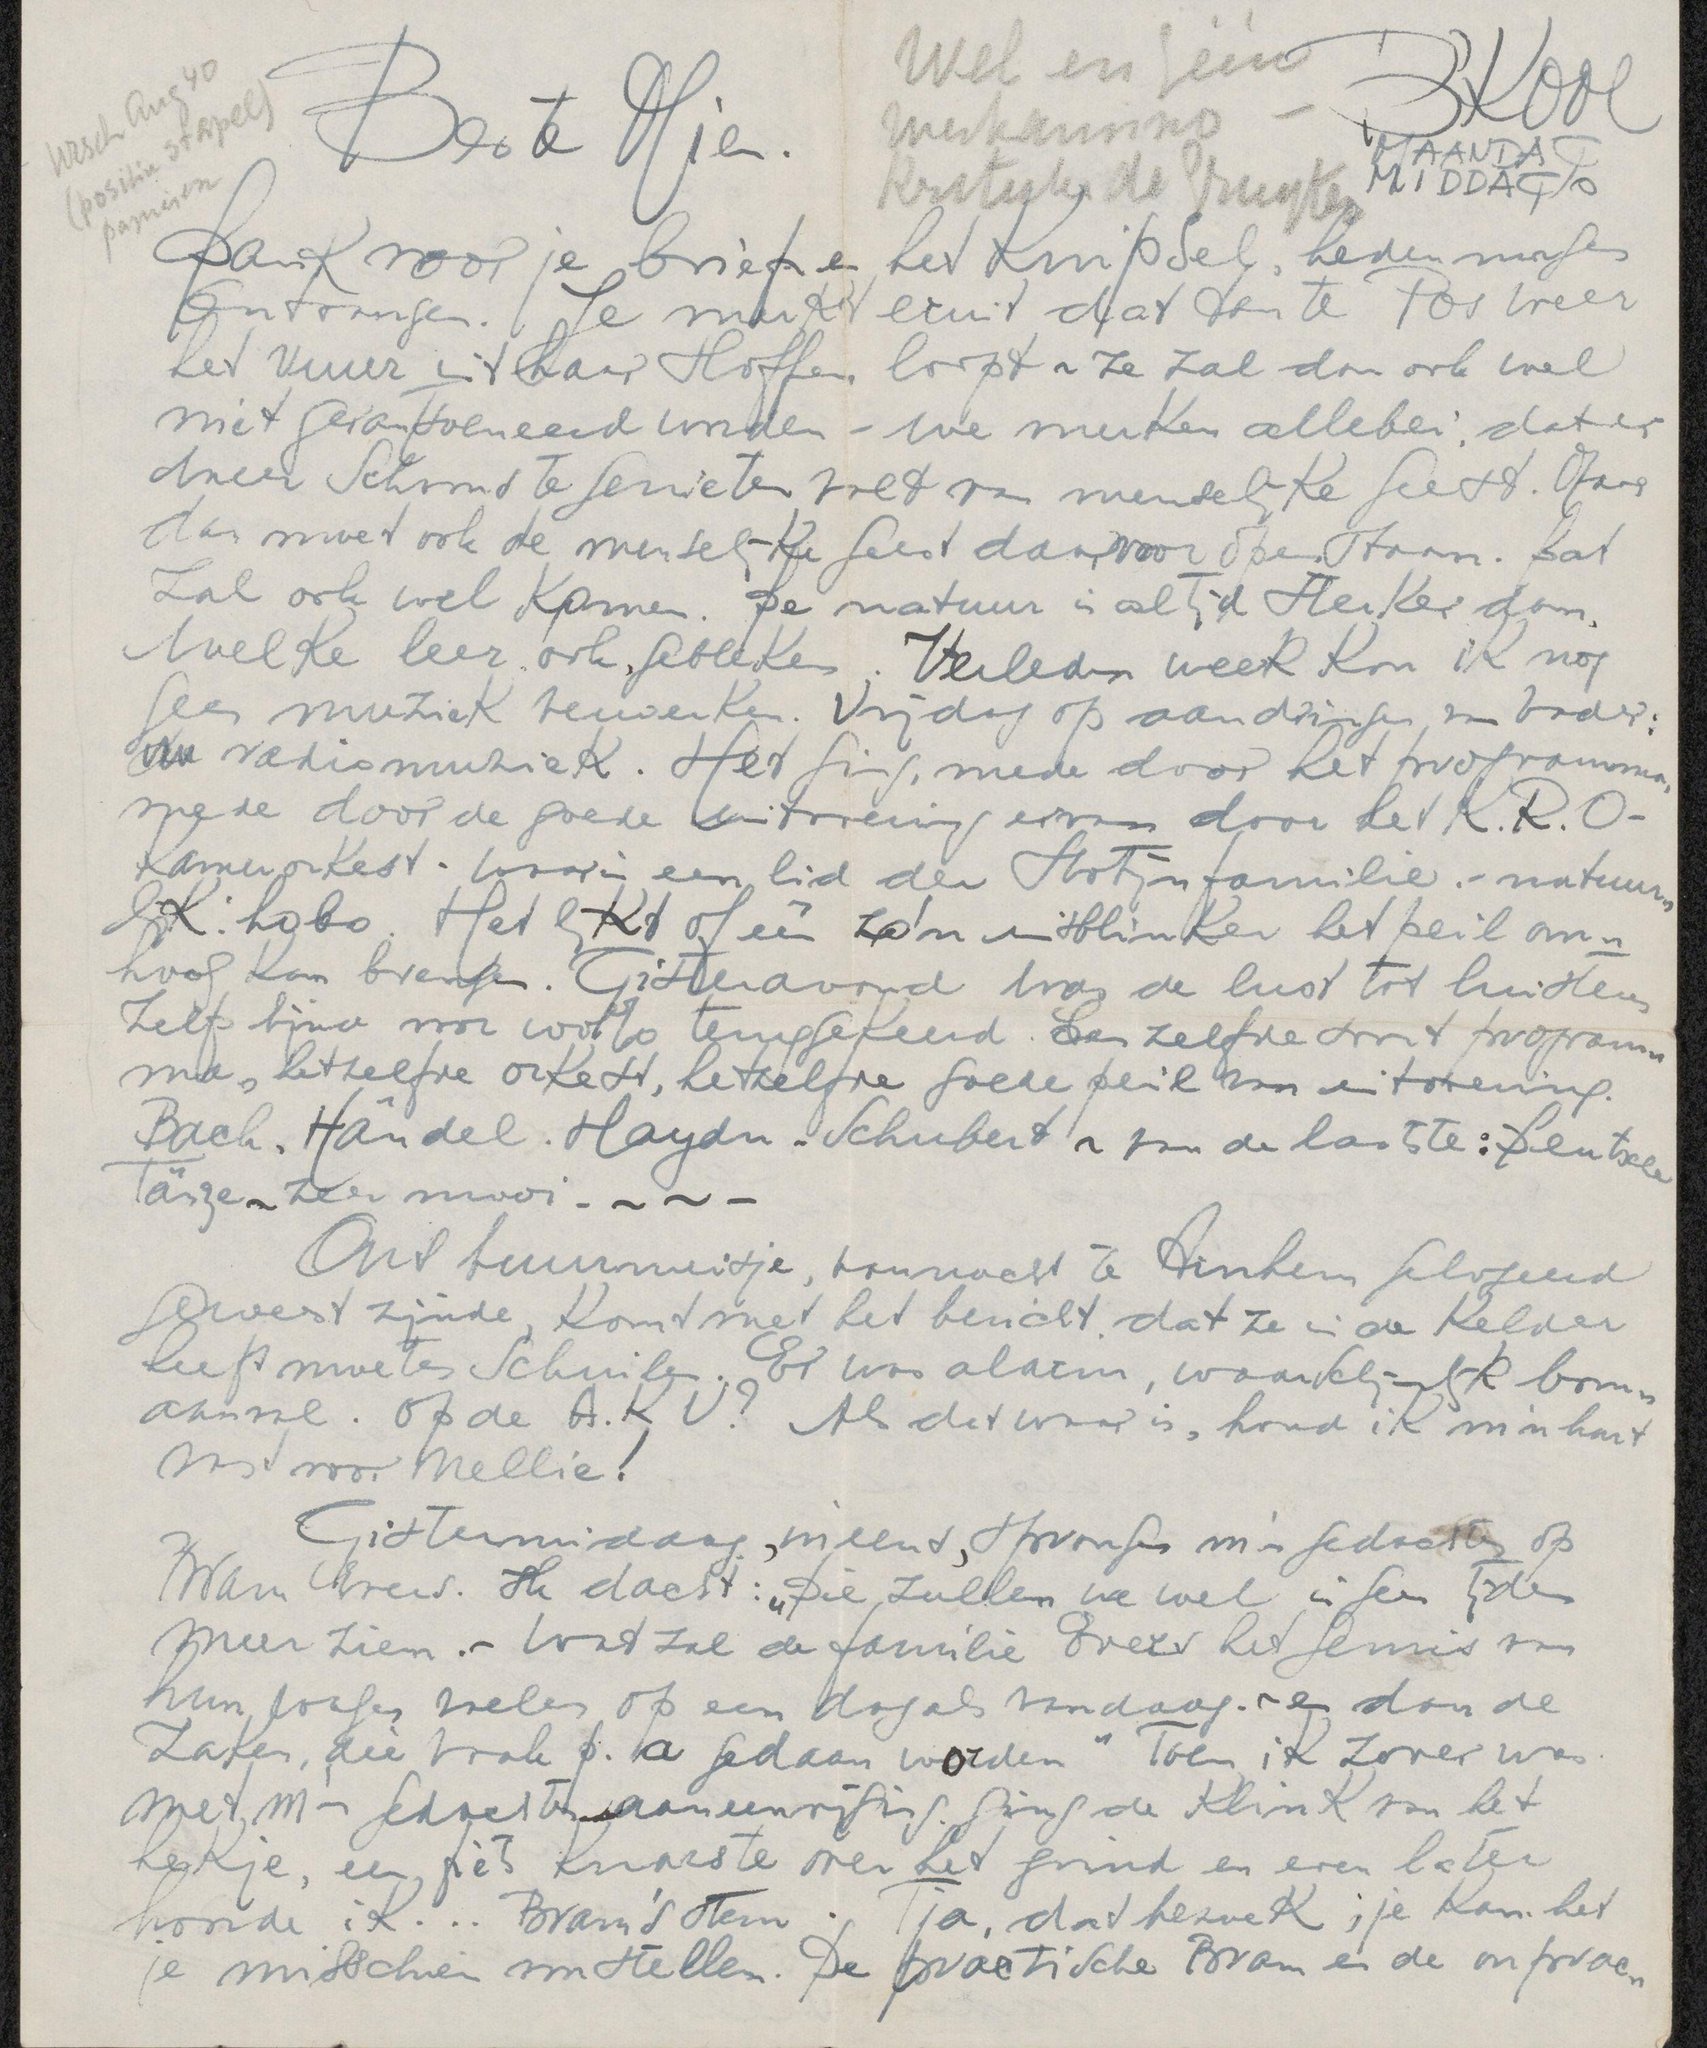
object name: letter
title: Brief aan Mien Cambier van Nooten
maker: dick ket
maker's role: draughtsman, print maker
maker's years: 1902-1940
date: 1912-1940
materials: ink, paper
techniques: pen, writing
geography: bennekom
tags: mien cambier van nooten, johan mekkink, singapore, w. jos de gruyter, music, literature ~ arts, arnhem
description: Brief gedateerd 'wrsch Aug '40' in latere hand.